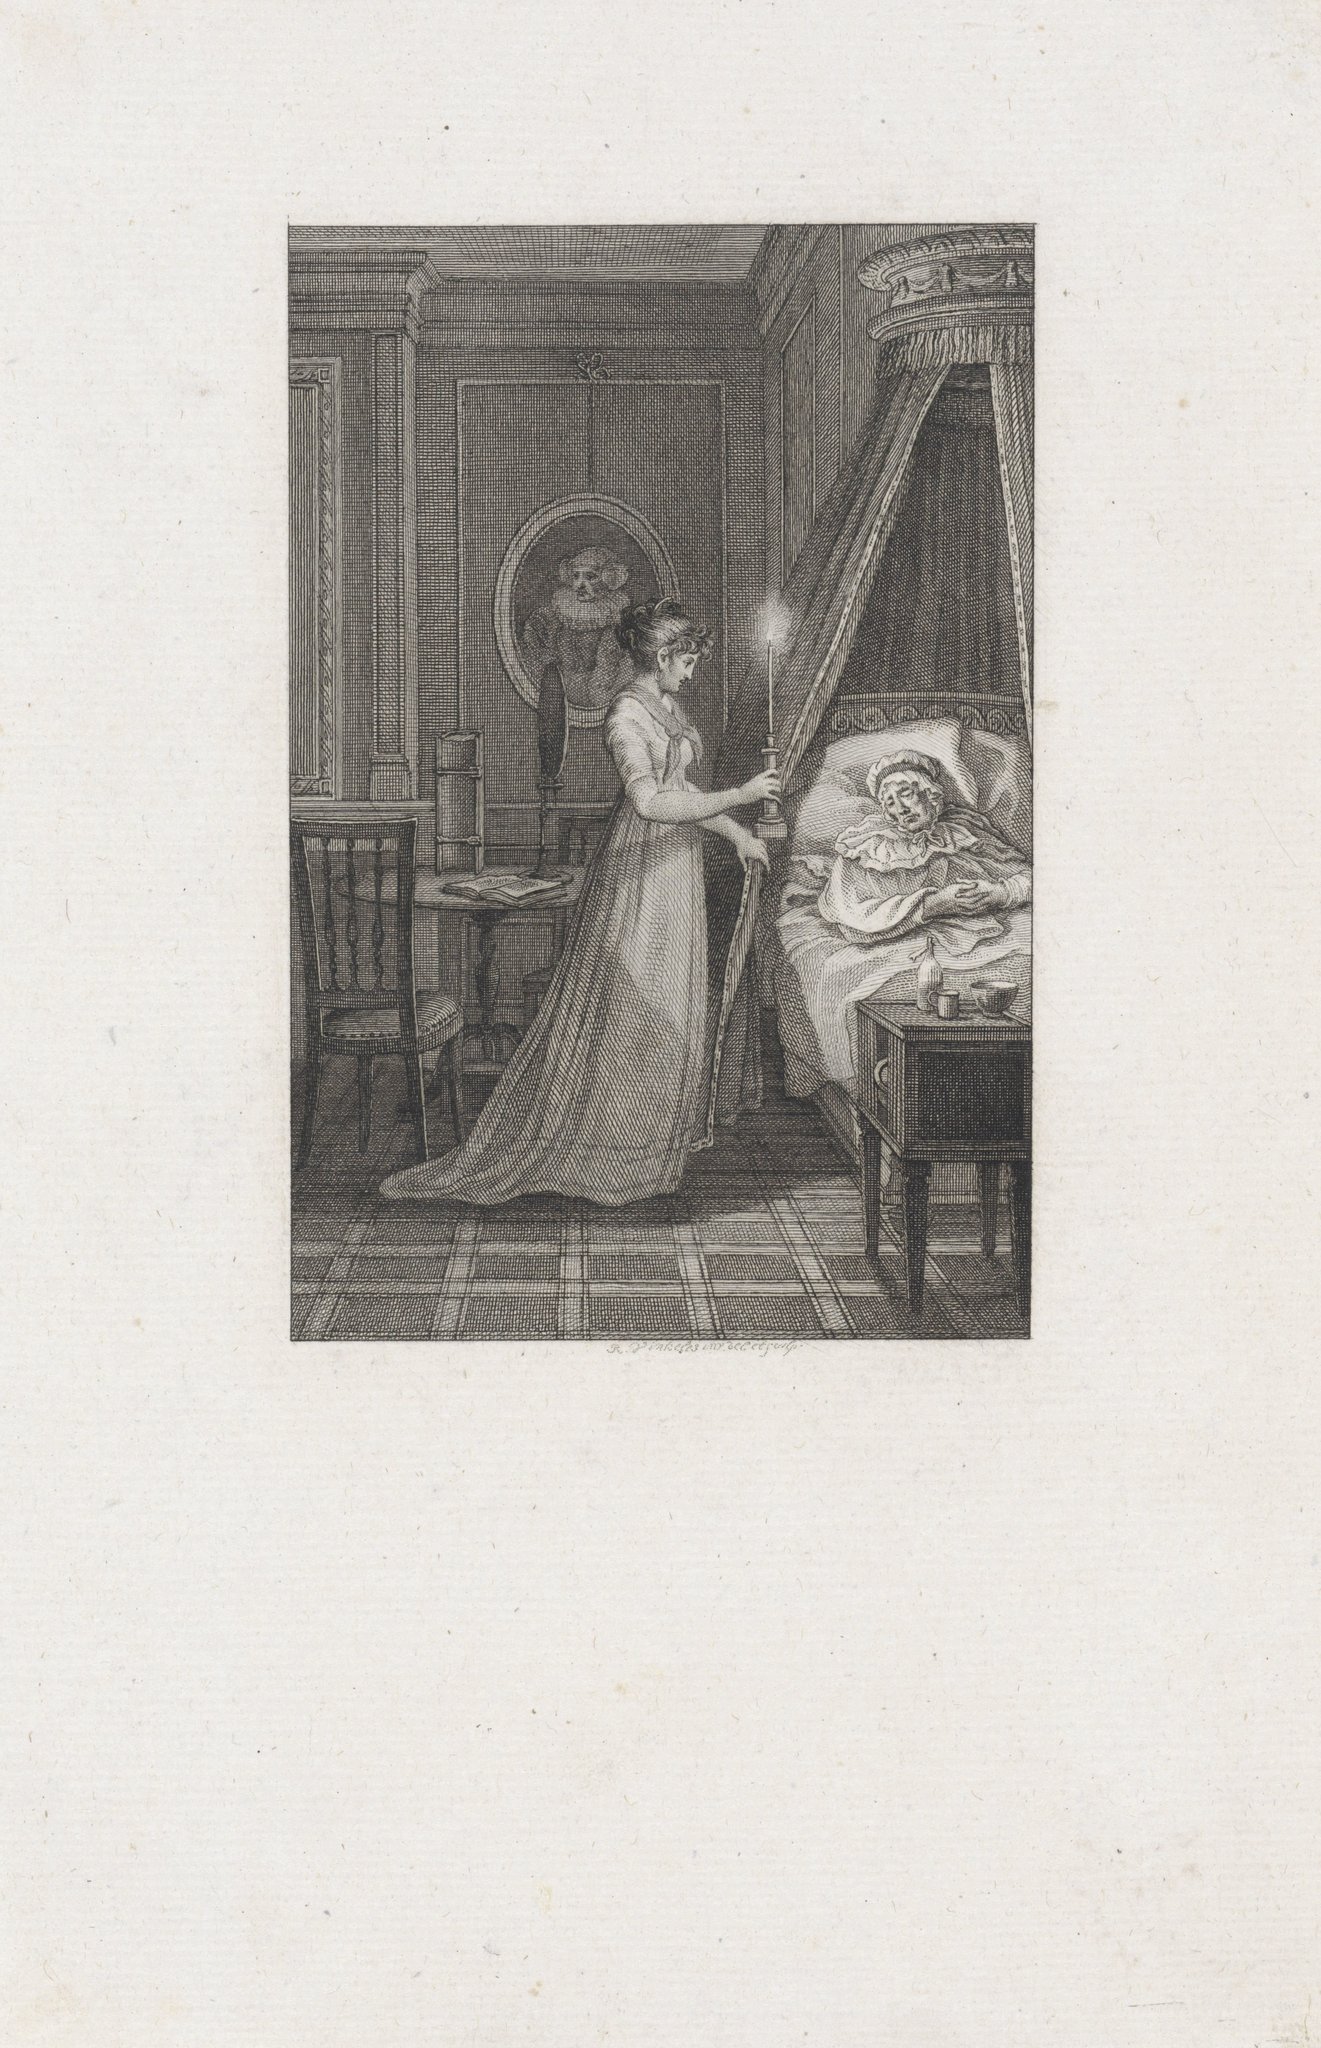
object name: print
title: Jonge vrouw bezoekt een oude slapende vrouw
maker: reinier vinkeles (i)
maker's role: draughtsman, print maker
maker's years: 1741-1816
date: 1806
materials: paper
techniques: engraving, etching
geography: amsterdam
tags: sleeping in bed, candle, picture, painting, bedroom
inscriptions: collector's mark: Lugt 240